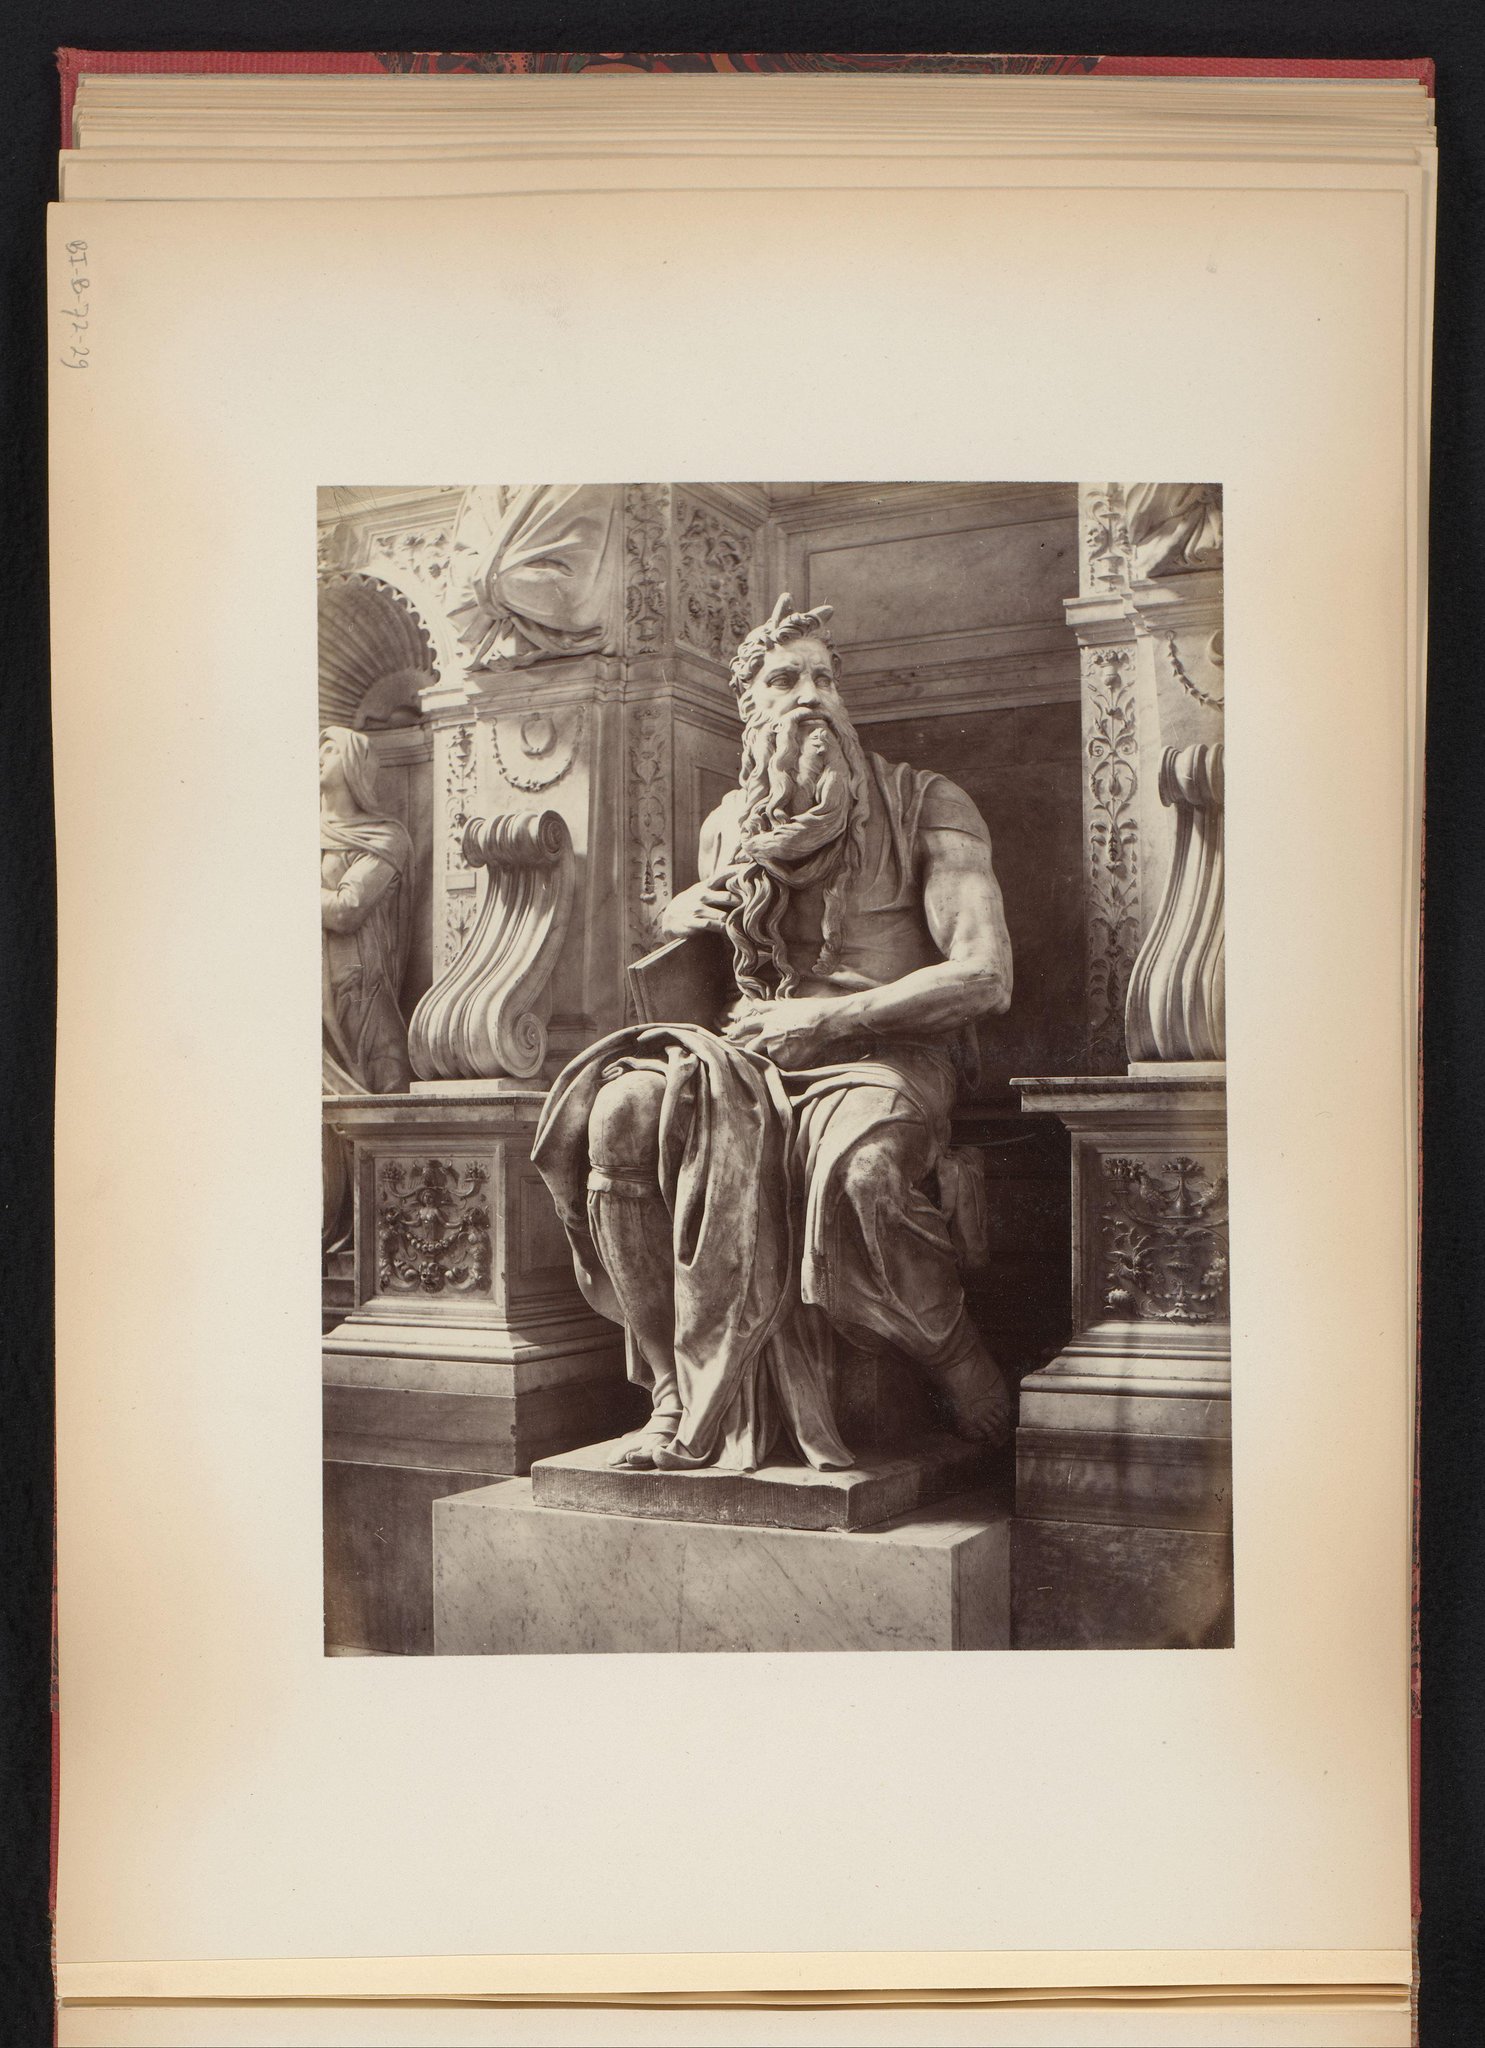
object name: album leaf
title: Sculptuur van Mozes door Michelangelo, monument voor Julius II, S. Pietro in Vincoli te Rome, Italië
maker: Anonymous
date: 1870-1890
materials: paper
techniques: albumen print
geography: rome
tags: parts of church interior, monument, statue, sculpture